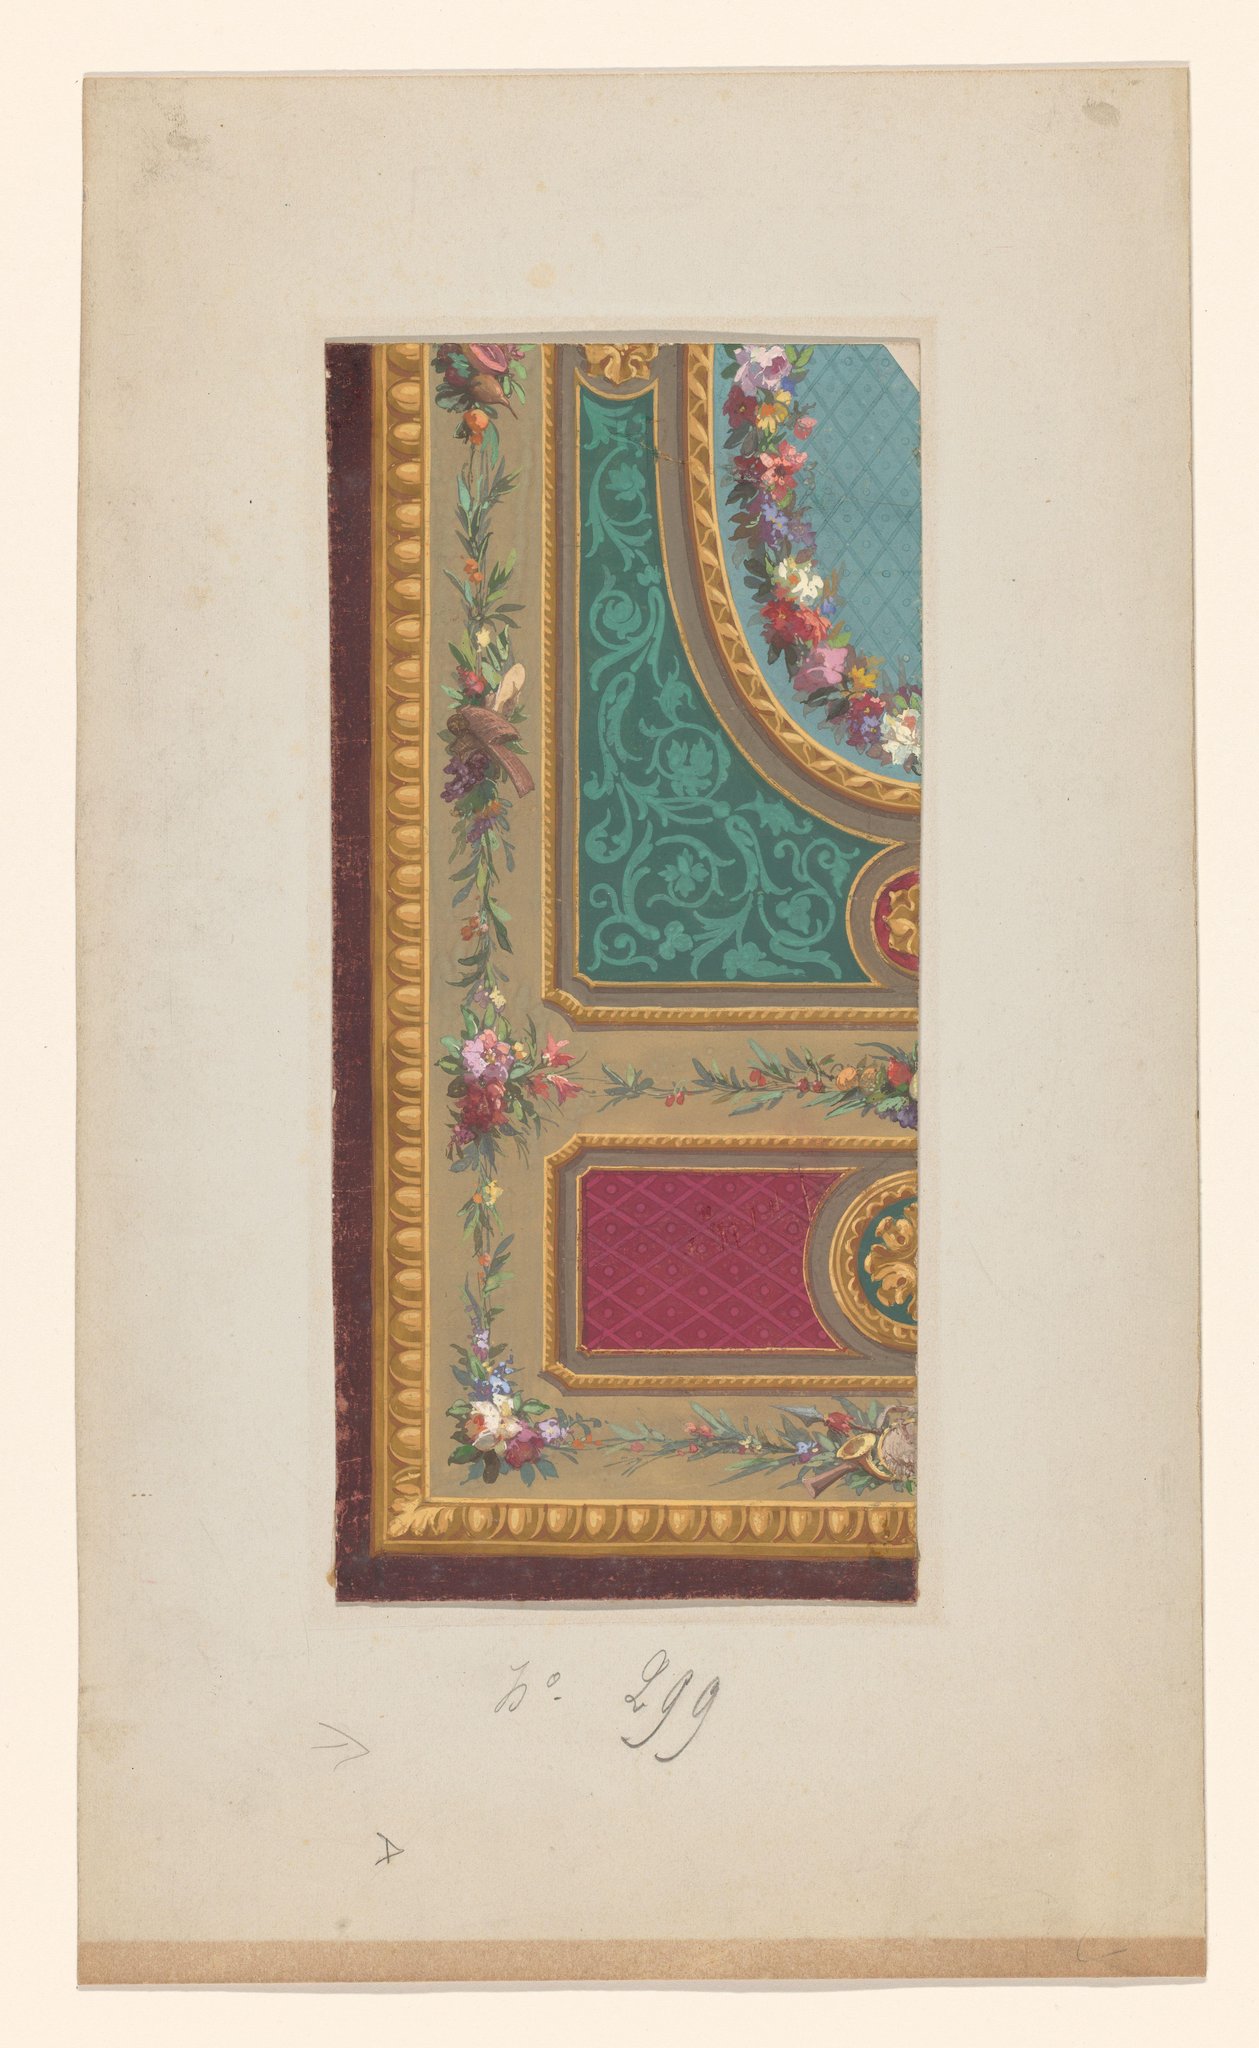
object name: design drawing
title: Ontwerp voor een hoek van een tapijt met een ovaal turquoise middenveld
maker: Anonymous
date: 1850-1880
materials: cardboard, gouache, paper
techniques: pasting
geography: france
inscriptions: stamp: ‘TAPIS ET ÉTOFFES D’AMEUBLEMENT / W. CHOCQUEEL / 16, rue Vivienne, PARIS / TOURCOING (…) AUBUSSON (Creuse)’, number: ‘No. 299’